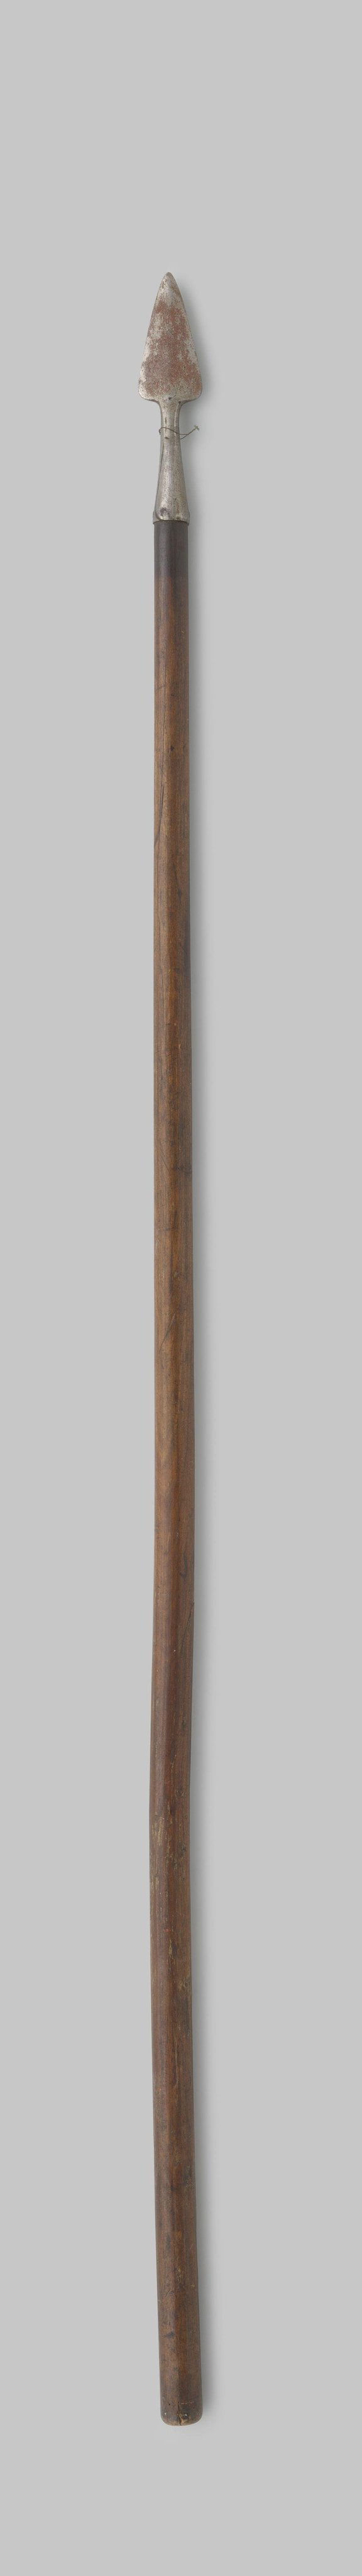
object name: pike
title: IJzeren piek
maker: Anonymous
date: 1599-1899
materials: iron, wood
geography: netherlands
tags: netherlands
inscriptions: number: ‘Ca-88’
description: IJzeren piek op een stok. De kling van de piek heeft de vorm van een driehoek, in het midden een gebolde middengraat welke doorloopt naar de punt. De kling heeft een korte smalle hals en verbreedt vervolgens weer cylindervormig alwaar een klinknagel de schacht en de kling aaneen houdt. In de schacht zit een lichte verbuiging.